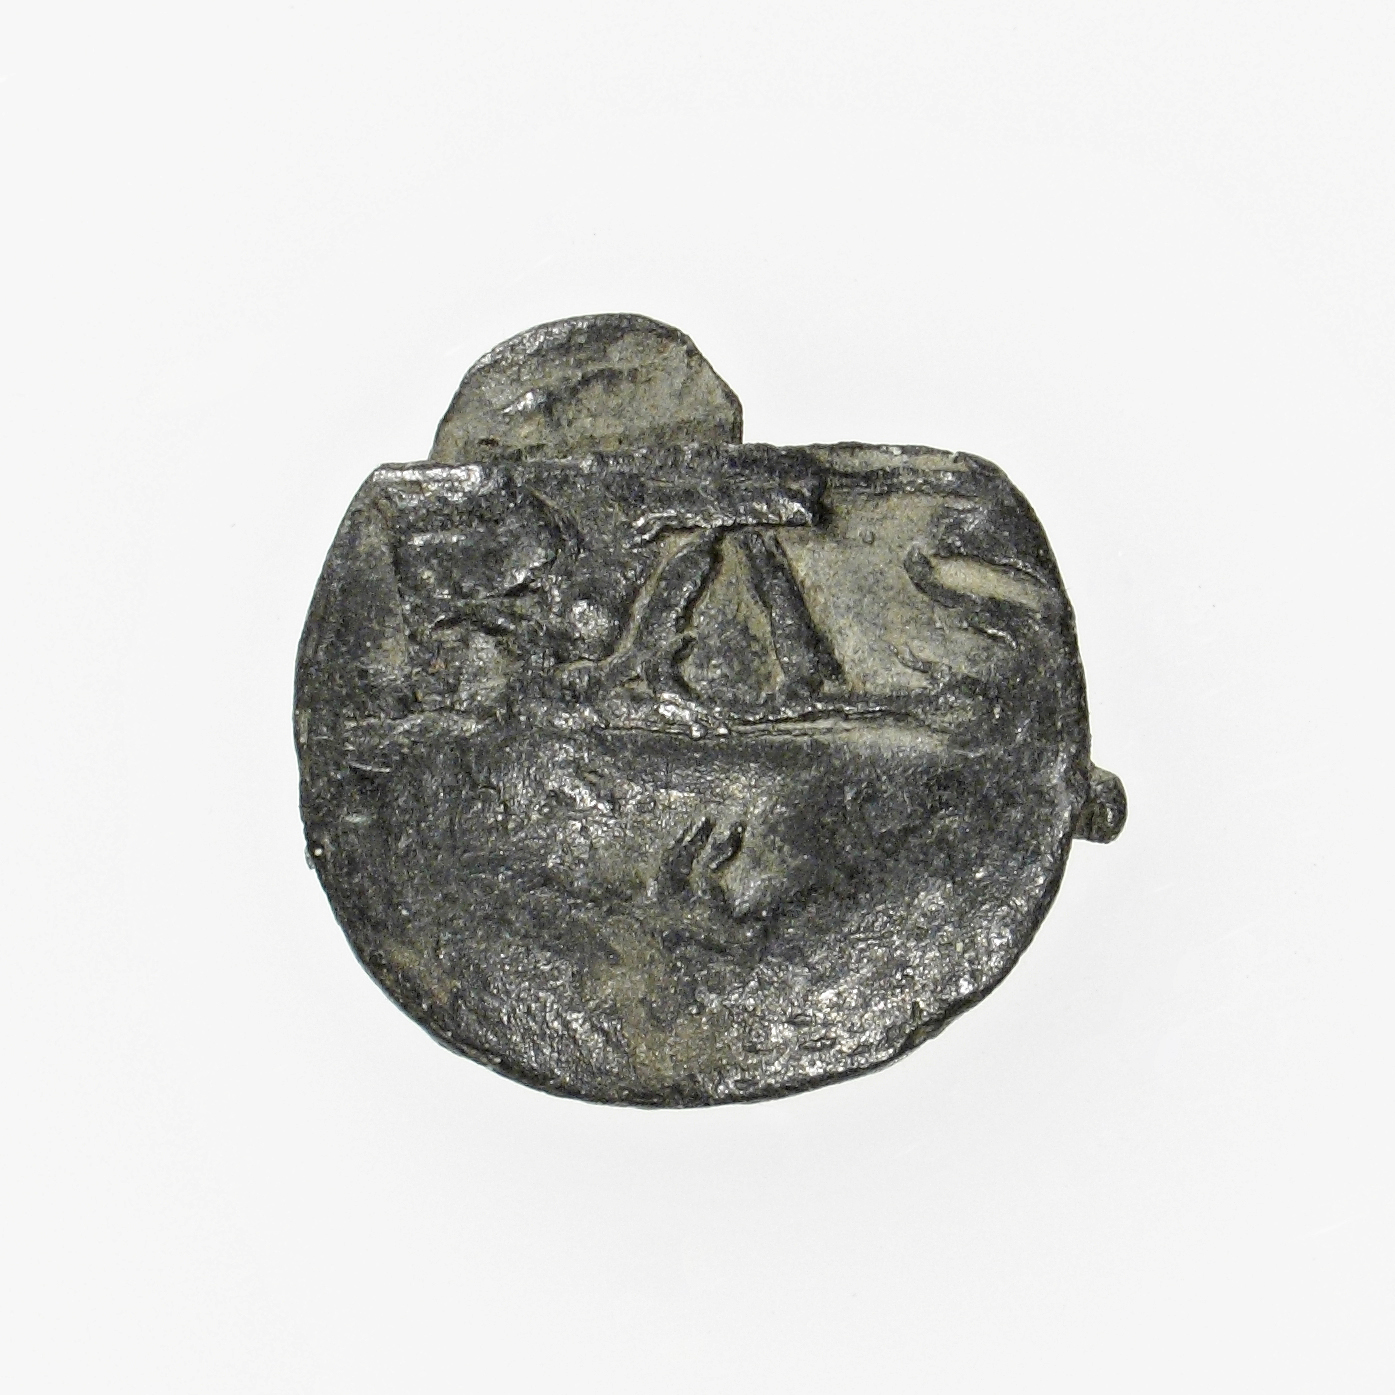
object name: pilgrim's badge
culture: french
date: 1301-1600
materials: lead